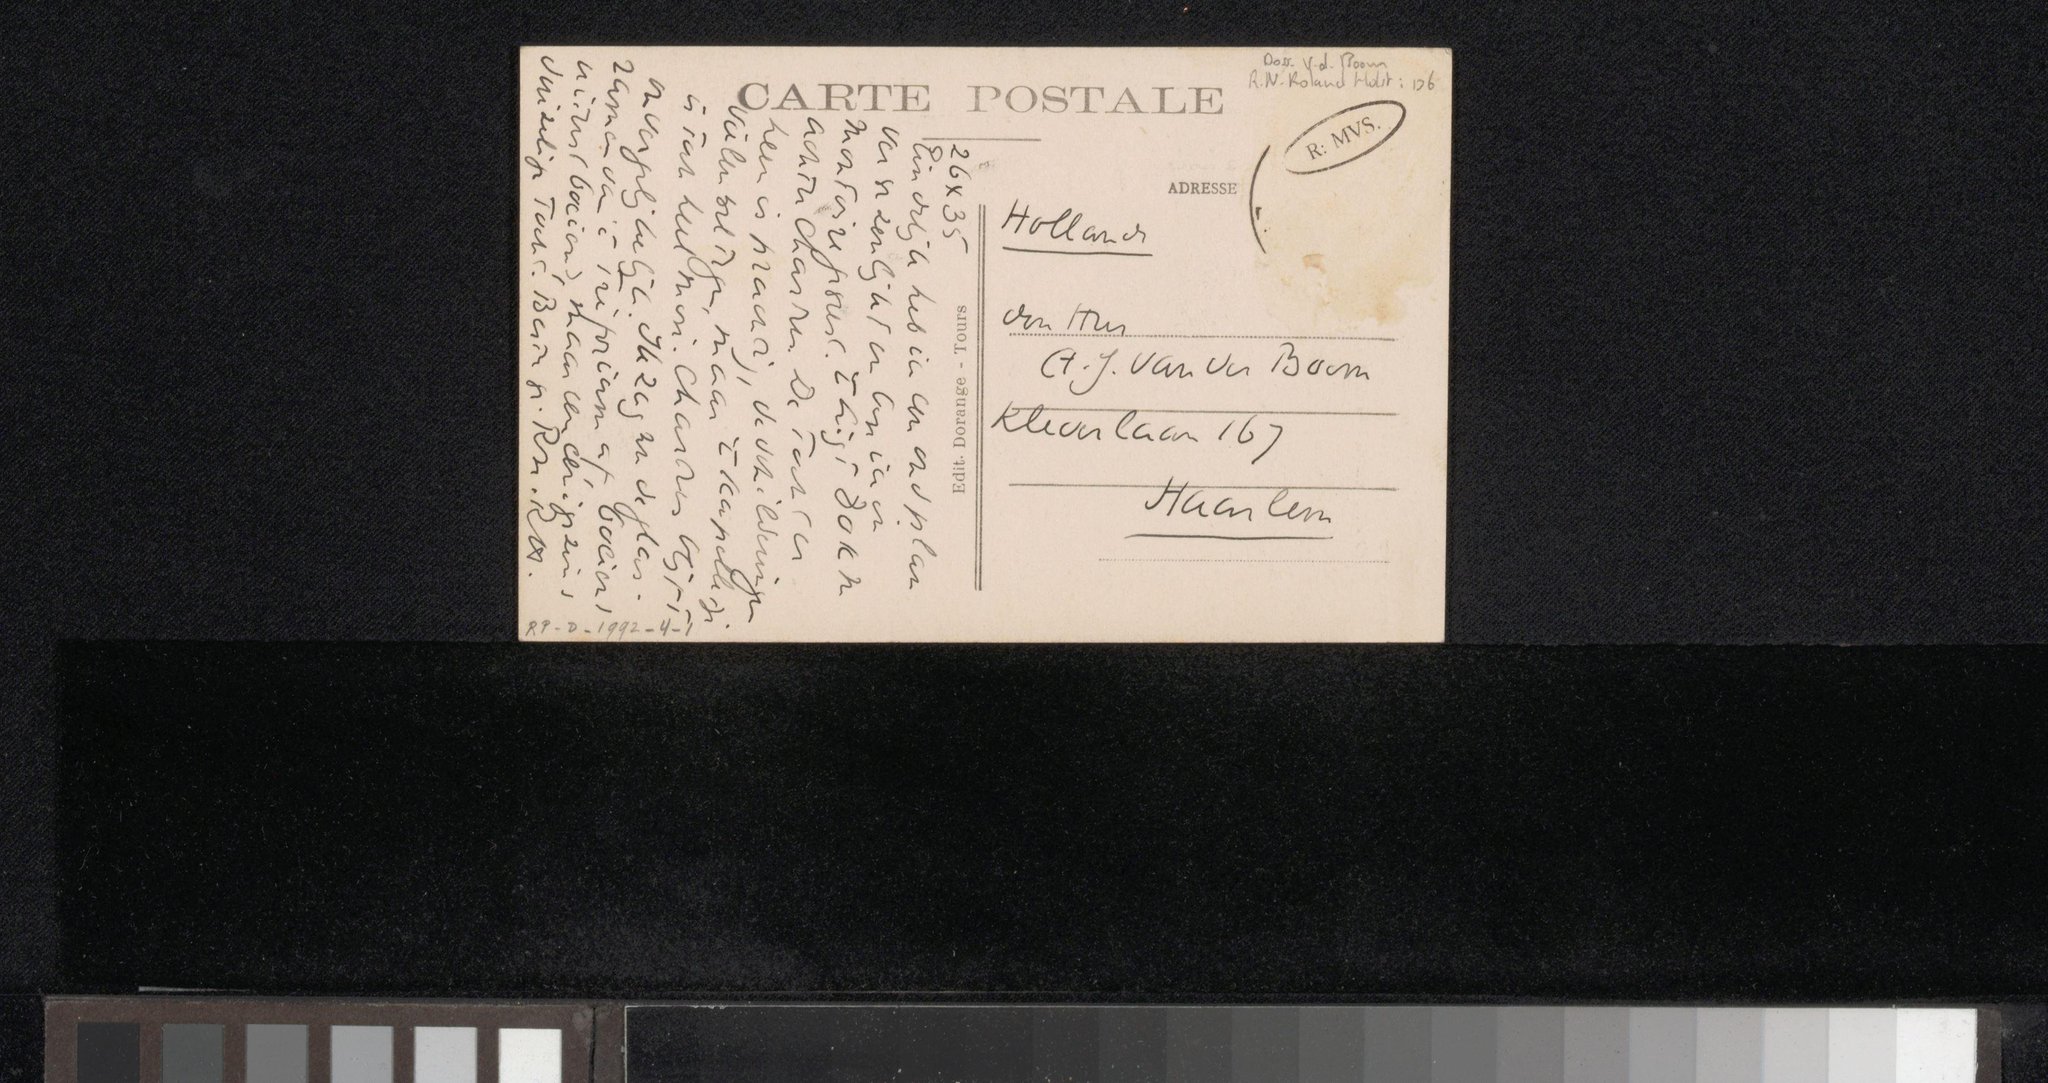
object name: ansichtkaart, prentbriefkaart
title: Prentbiefkaart aan A. van der Boom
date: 1935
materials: cardboard, ink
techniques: photograph, pen, writing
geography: tours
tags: a. van der boom, applied arts, arts and crafts; industrial design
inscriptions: collector's mark: Lugt L.2228a